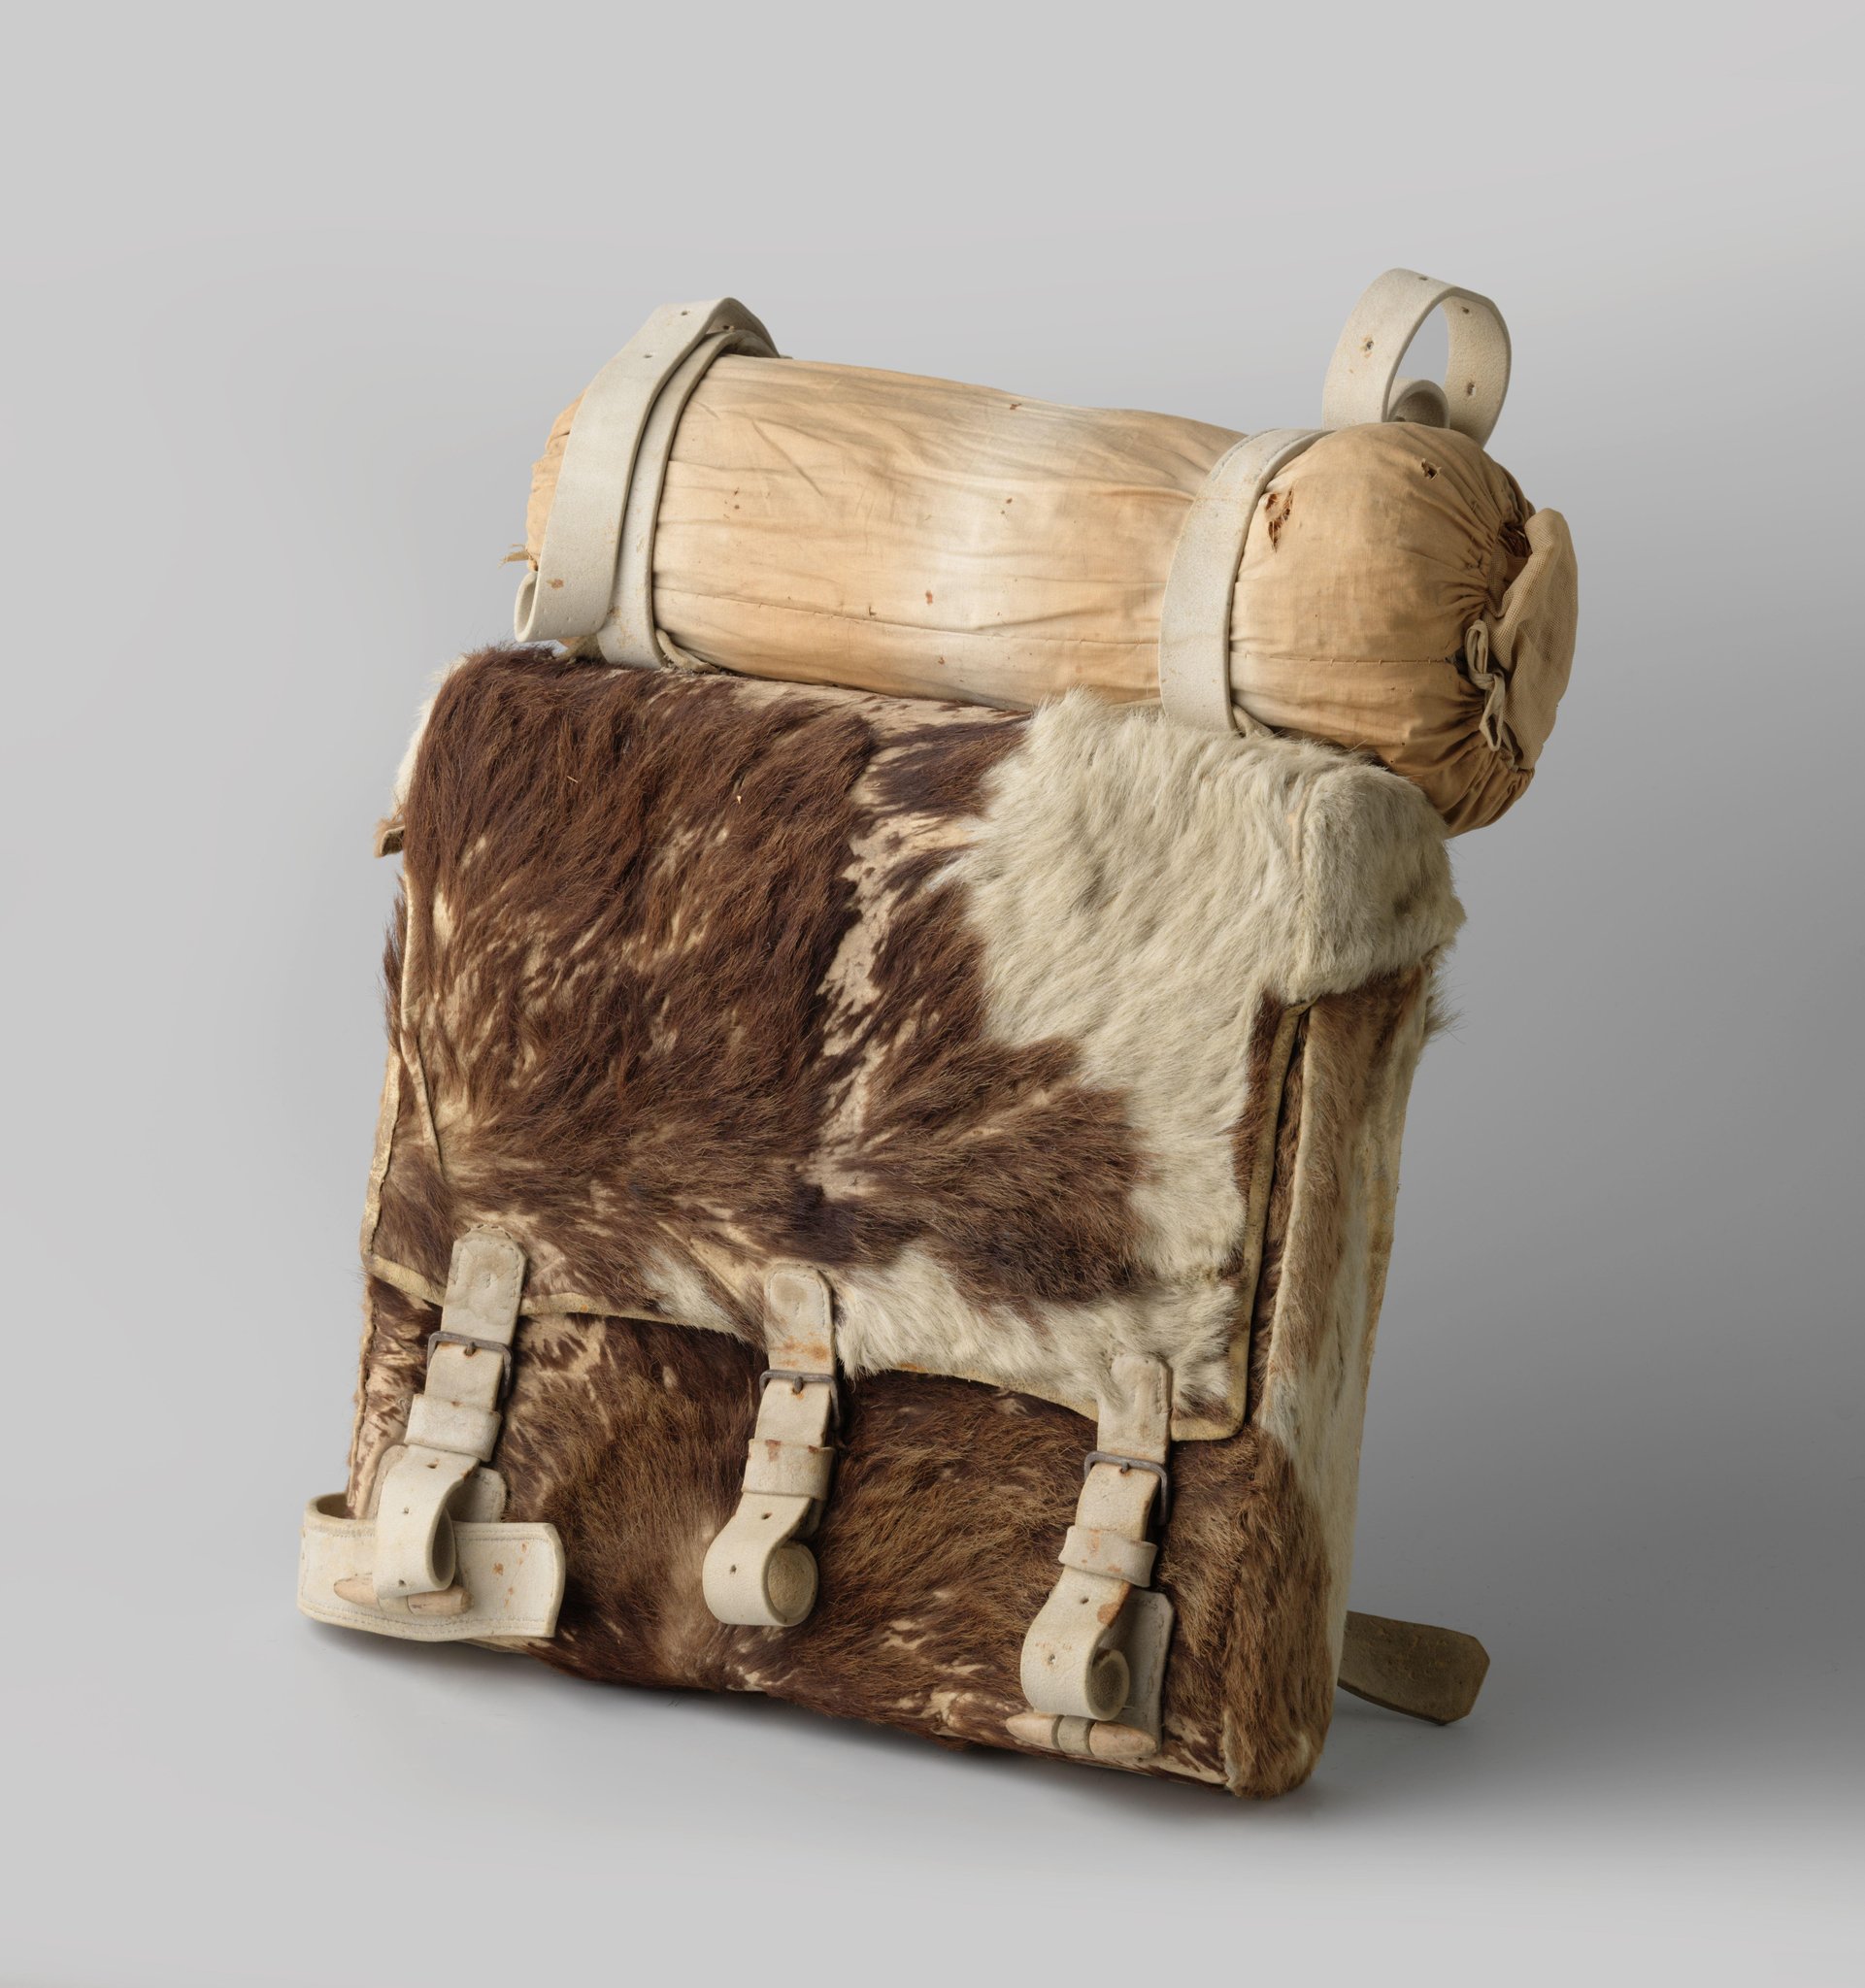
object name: combat rucksack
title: Ransel van bruin behaard vel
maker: Anonymous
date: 1825-1832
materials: iron, leather, textile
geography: netherlands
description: Ransel van bruin wit bont met witte riemen. Drie gespen aan voorzijde. Op de rughengsel aan de binnenzijde het nr. 240. Binnenzijde klep de nummers 1844 en 124..?. Binnenzijde v.z.v. houten bekisting. Op de bovenzijde een rol bevestigd aan ransel met twee wit leren riemen.